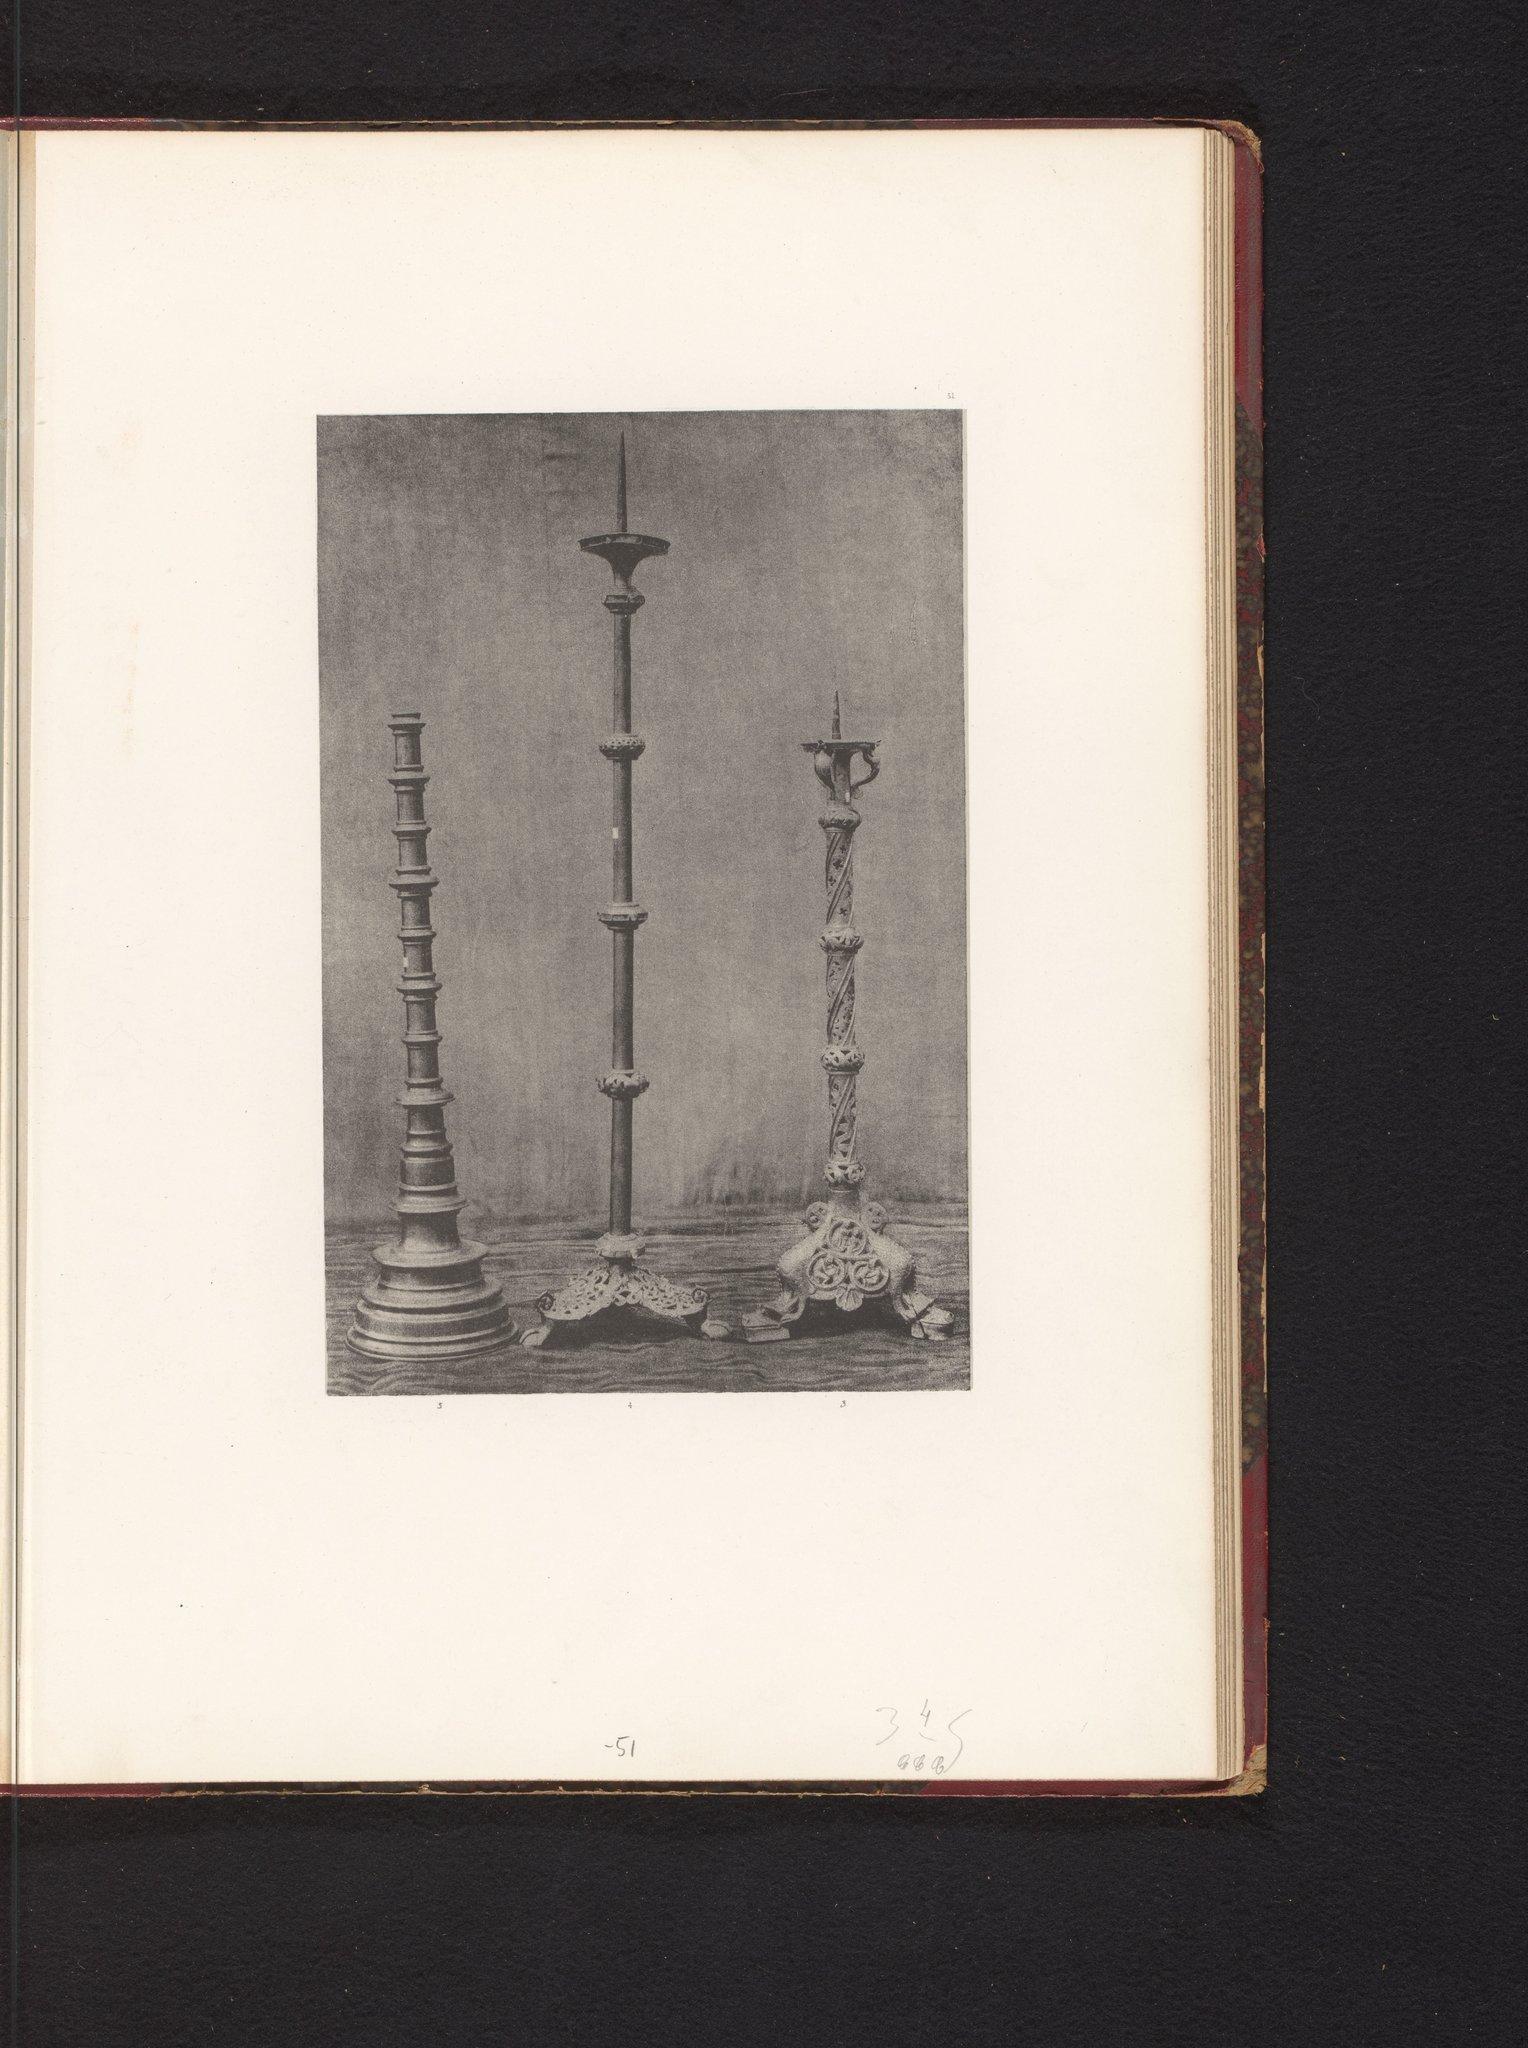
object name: page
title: Drie metalen kandelabers, opgesteld op een tentoonstelling over religieuze objecten uit de middeleeuwen en renaissance in 1864 in Mechelen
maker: joseph maes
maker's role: fotograaf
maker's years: 1838-1908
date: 1864-1866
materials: paper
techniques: photolithography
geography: mechelen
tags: chandelier, candelabrum, mechelen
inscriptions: number: ‘3 4 5/ [...]’, number: ‘-51’, number: ‘3 - 4 - 5’